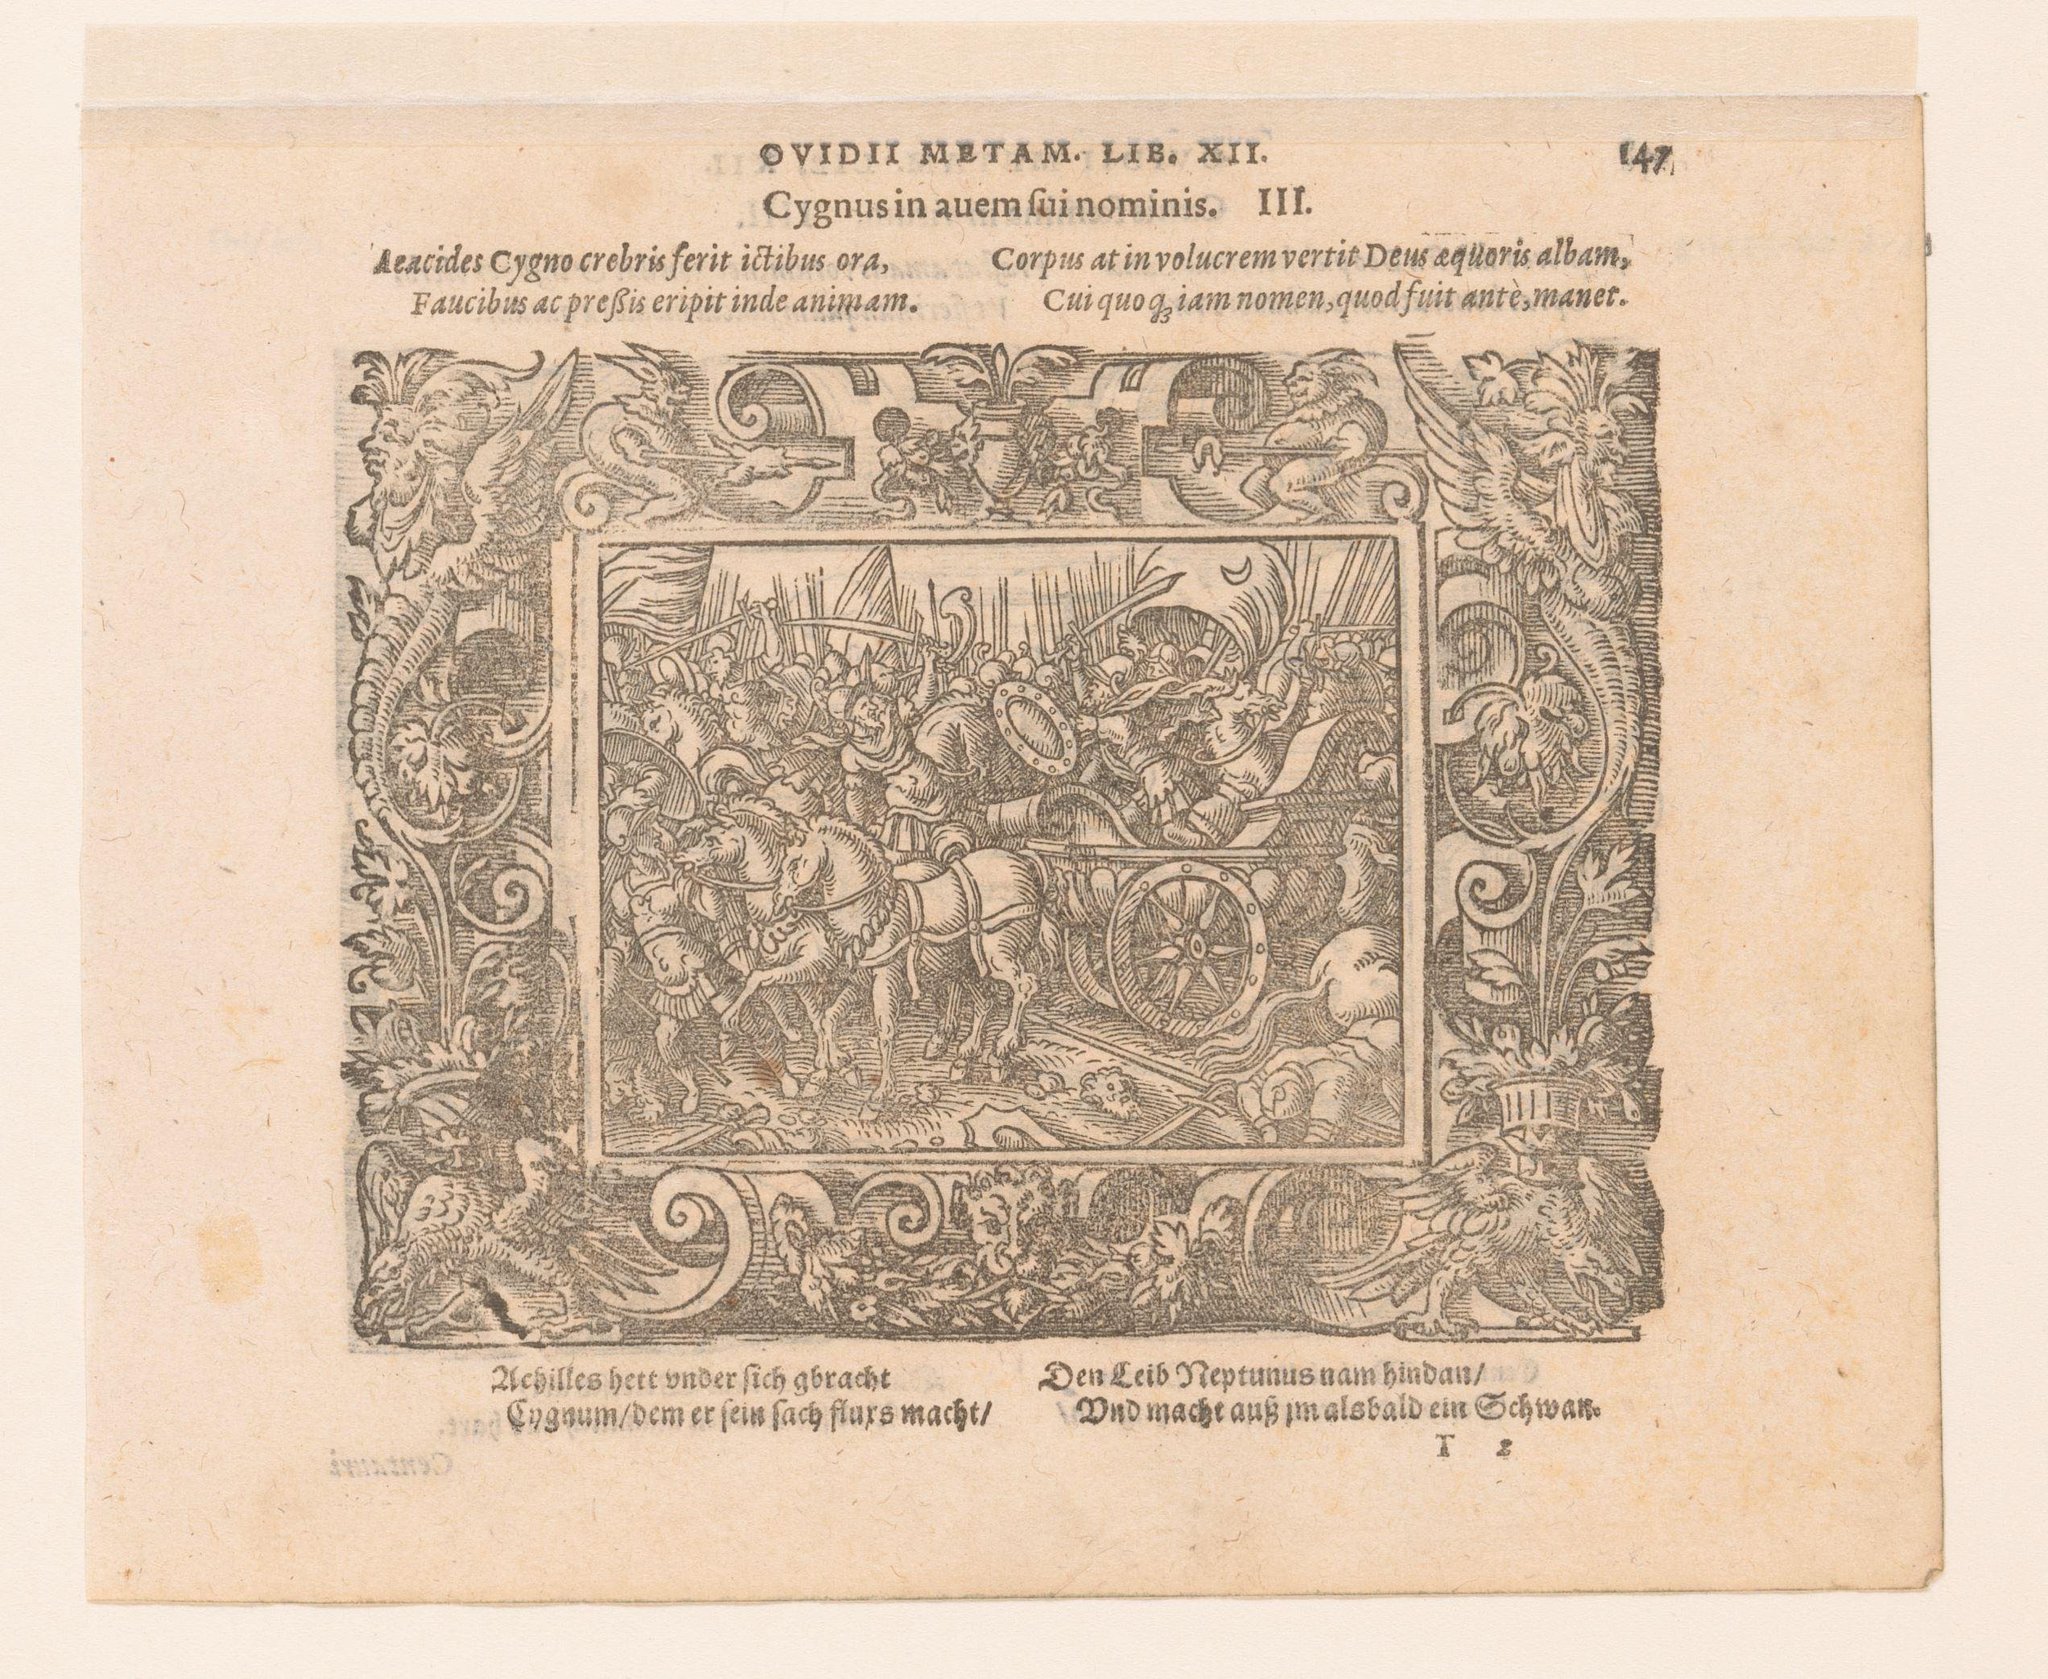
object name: book illustration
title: Gevecht tussen Hector en Cygnus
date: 1569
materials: paper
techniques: letterpress printing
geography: frankfurt am main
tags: scrollwork, strapwork ~ ornament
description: Illustratie bij de Metamorfosen van Ovidius, afkomstig uit de publicatie: Posthius, Johannes. Tetrasticha in Ovidii metam. Frankfurt am Main: Georg Rab en Sigmund Feyerabend en erven Weigand Han, 1569. De voorstellingen en ornamentranden van deze boekillustraties zijn van twee aparte blokken gedrukt. Beide werden afzonderlijk van elkaar ook gebruikt voor andere publicaties, en de ornamentranden werden eveneens binnen deze publicatie meerdere keren gebruikt.